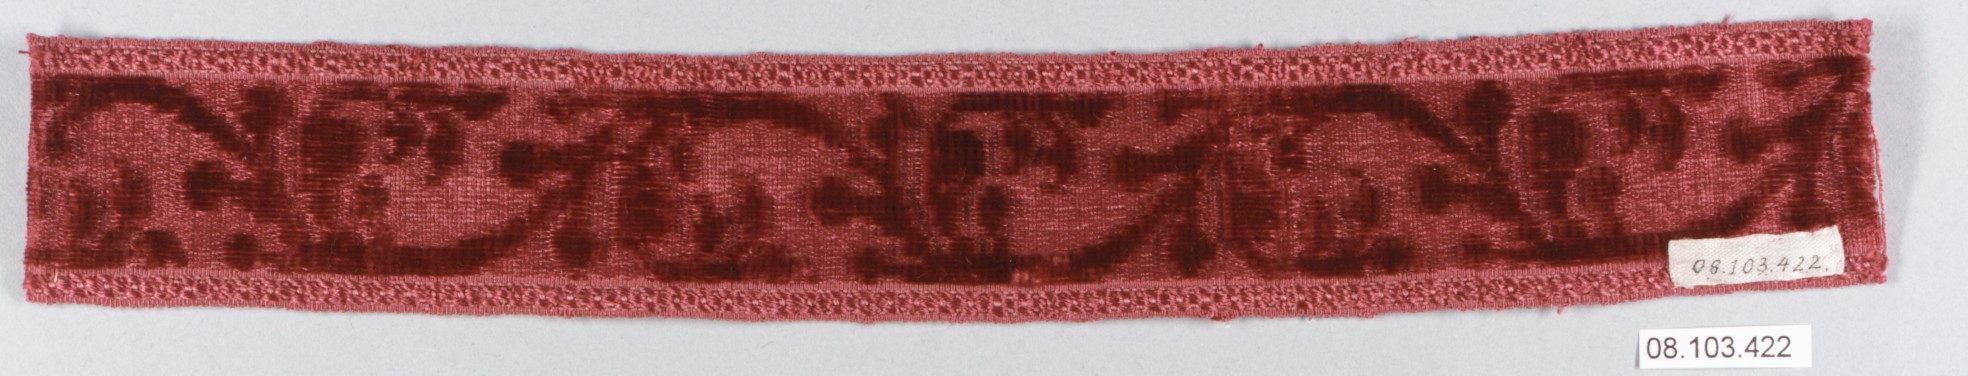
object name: galloon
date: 1701-1900